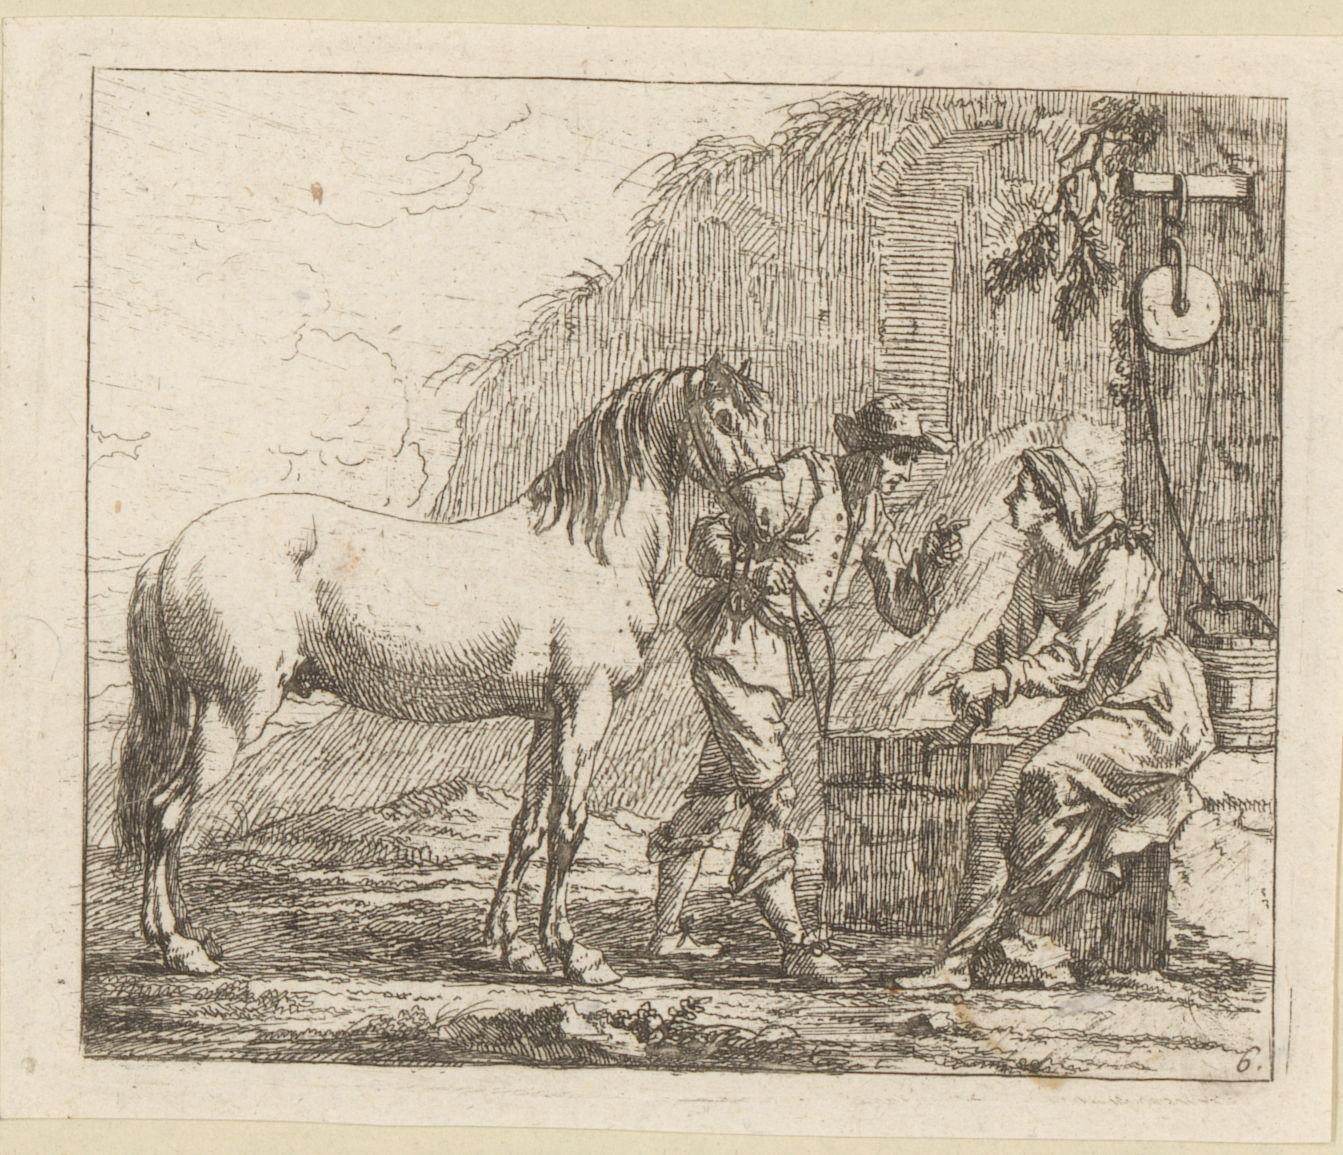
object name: print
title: Man met paard aan teugel en vrouw in gesprek bij een waterput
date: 1698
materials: paper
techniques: etching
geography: augsburg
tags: riding a horse, ass, or mule; rider, horseman, well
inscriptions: collector's mark: Lugt 240